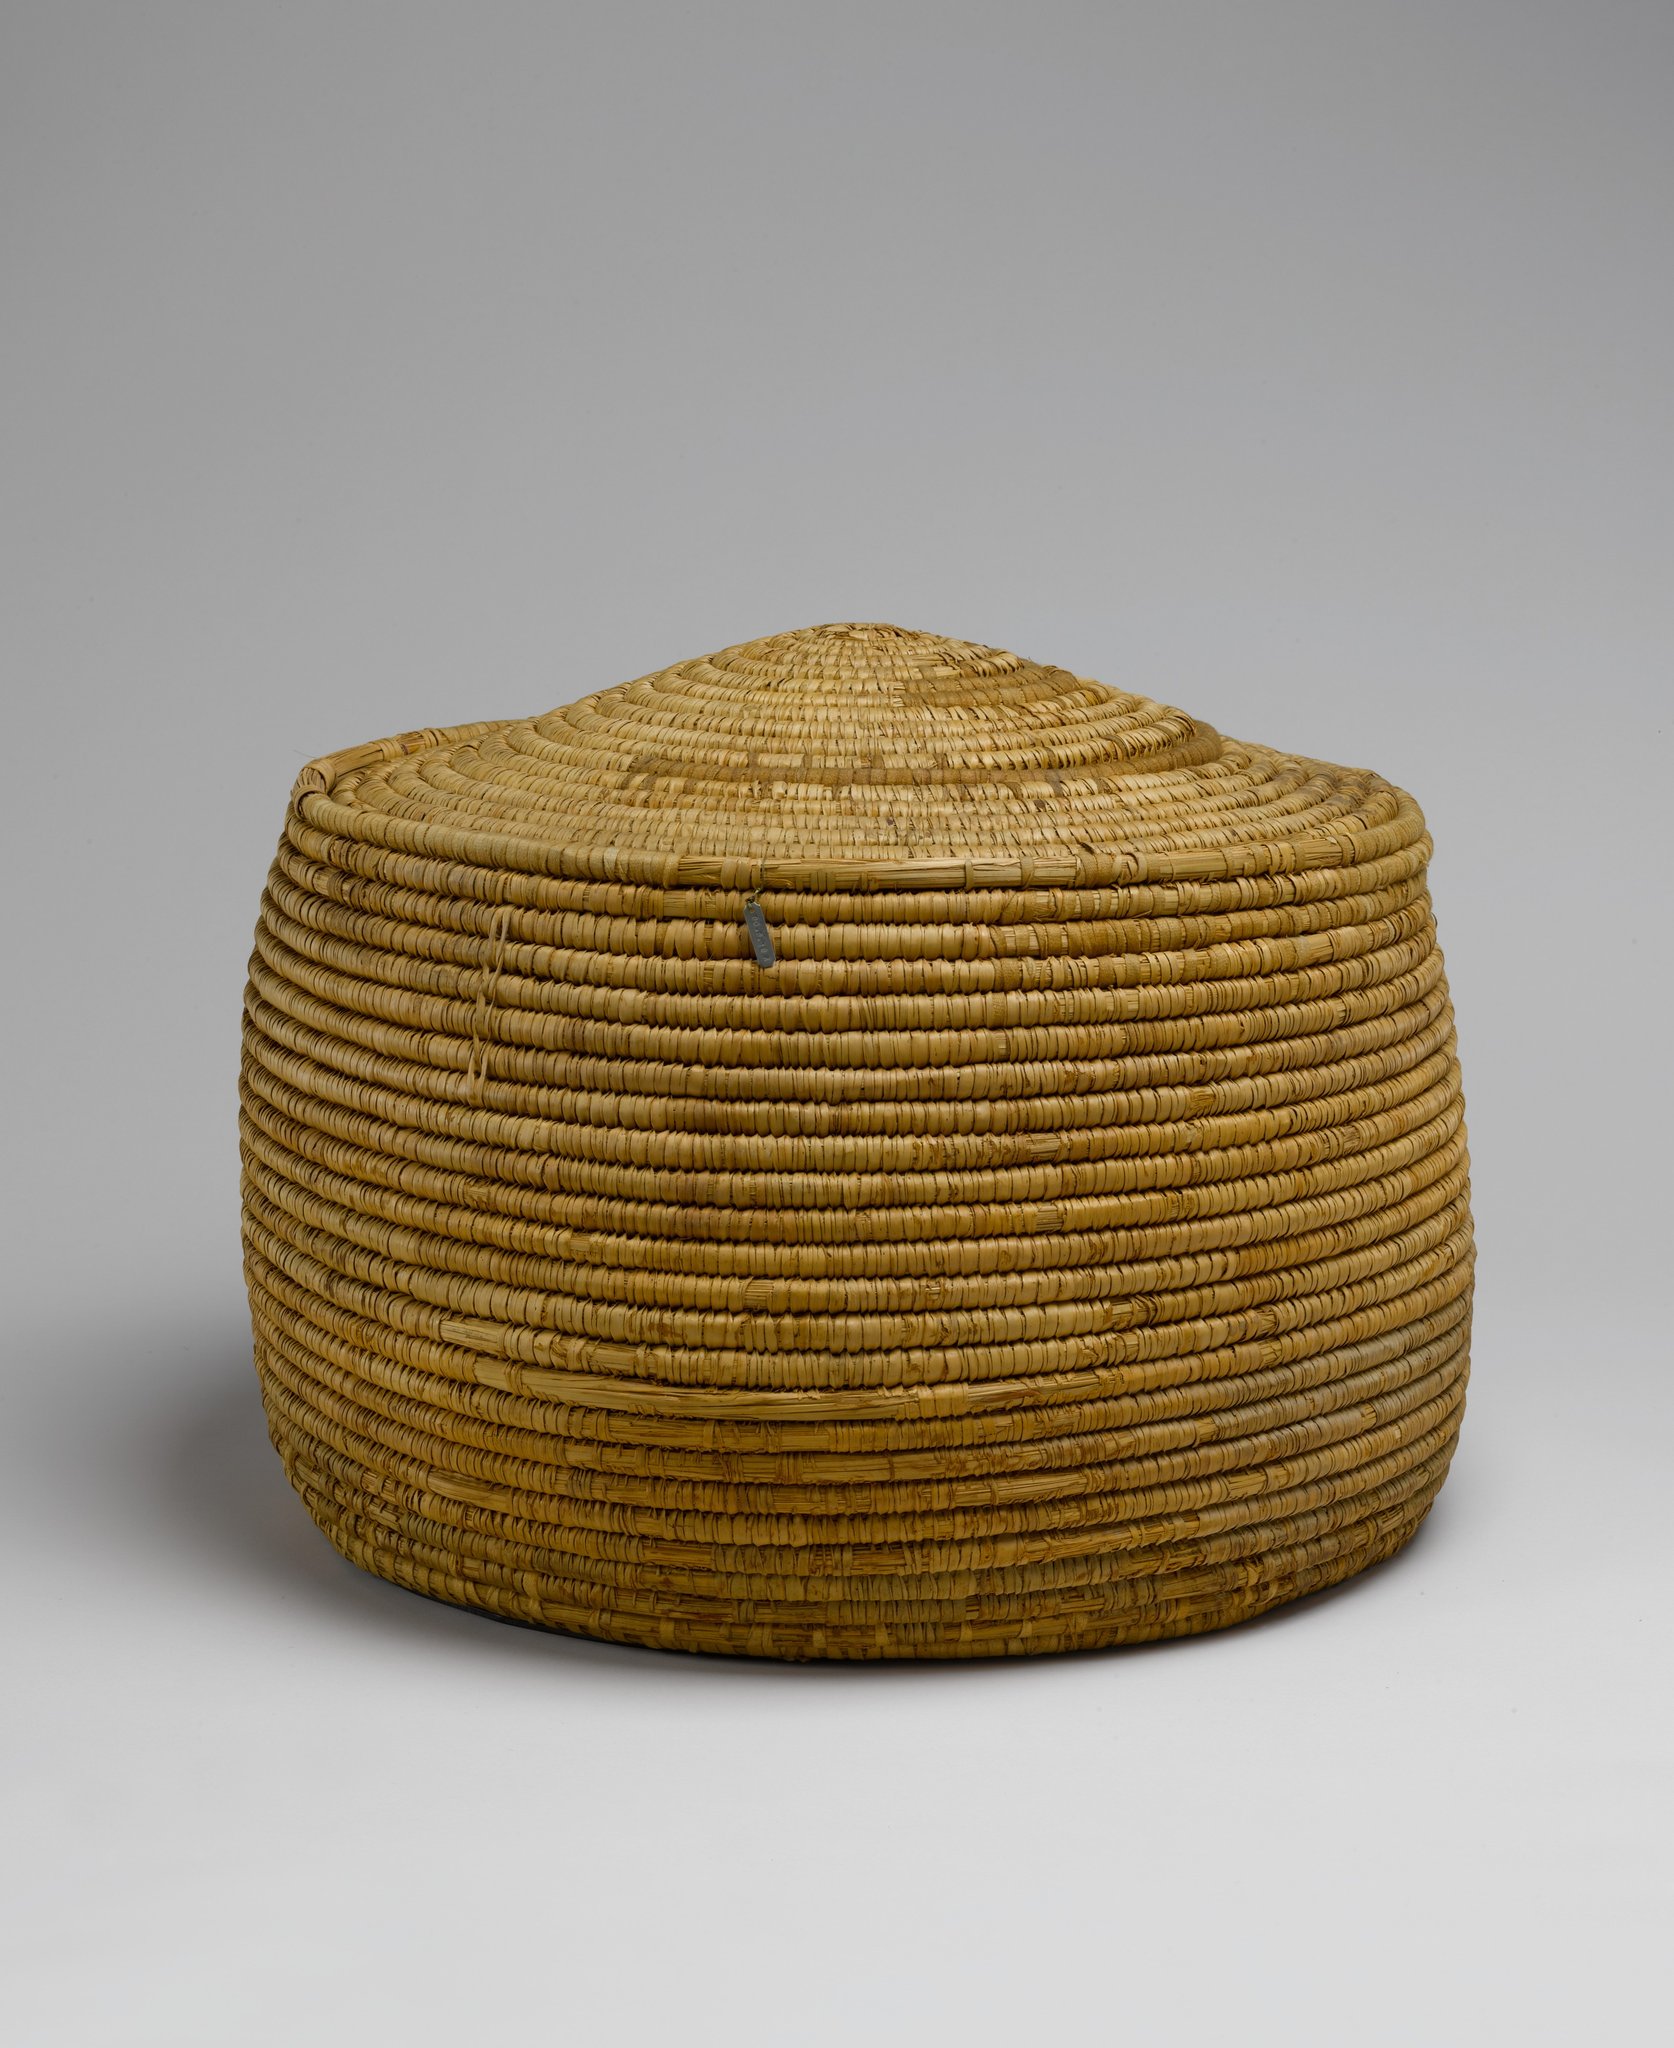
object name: basket, lid, meritamun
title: Large clothes basket D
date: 1525-1504 BCE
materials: leaf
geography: egypt